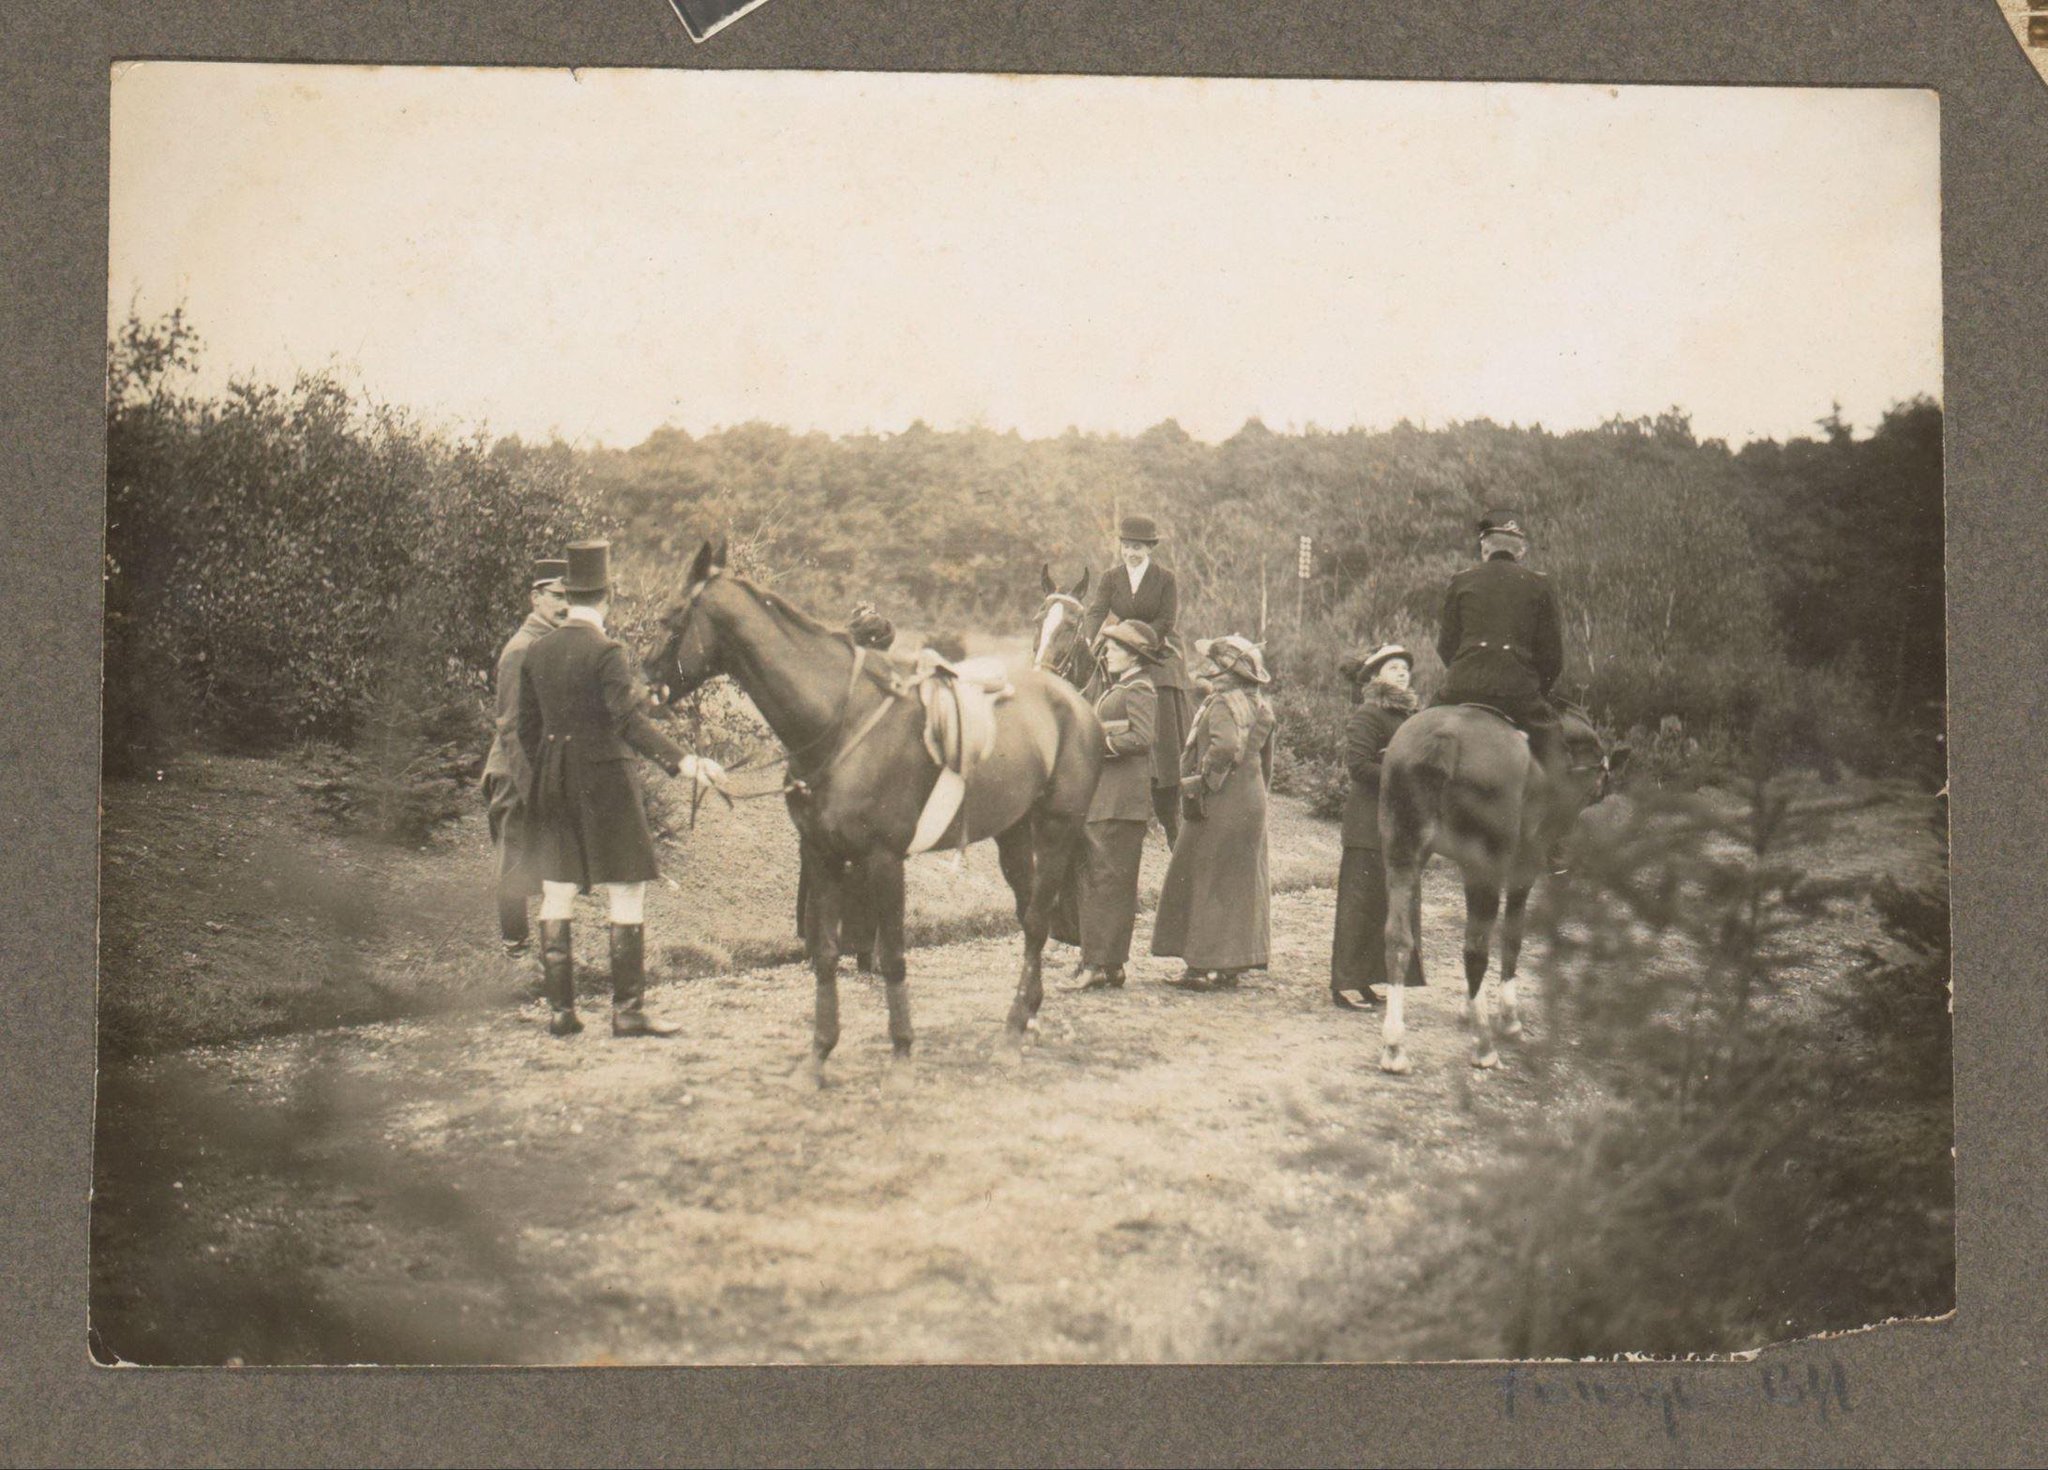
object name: album leaf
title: Ruitertafereel op Koninklijke Houtvesterij Het Loo: ruiters met publiek op een weg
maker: Anonymous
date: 1900-1925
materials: photographic support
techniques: gelatin silver print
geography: het loo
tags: riding a horse, ass, or mule; rider, horseman, hunting, chase, hunting-ground, forest path or lane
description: Onderdeel van Fotoalbum van de heer Brams, opperhoutvester van koningin Wilhelmina op Koninklijke Houtvesterij Het Loo.